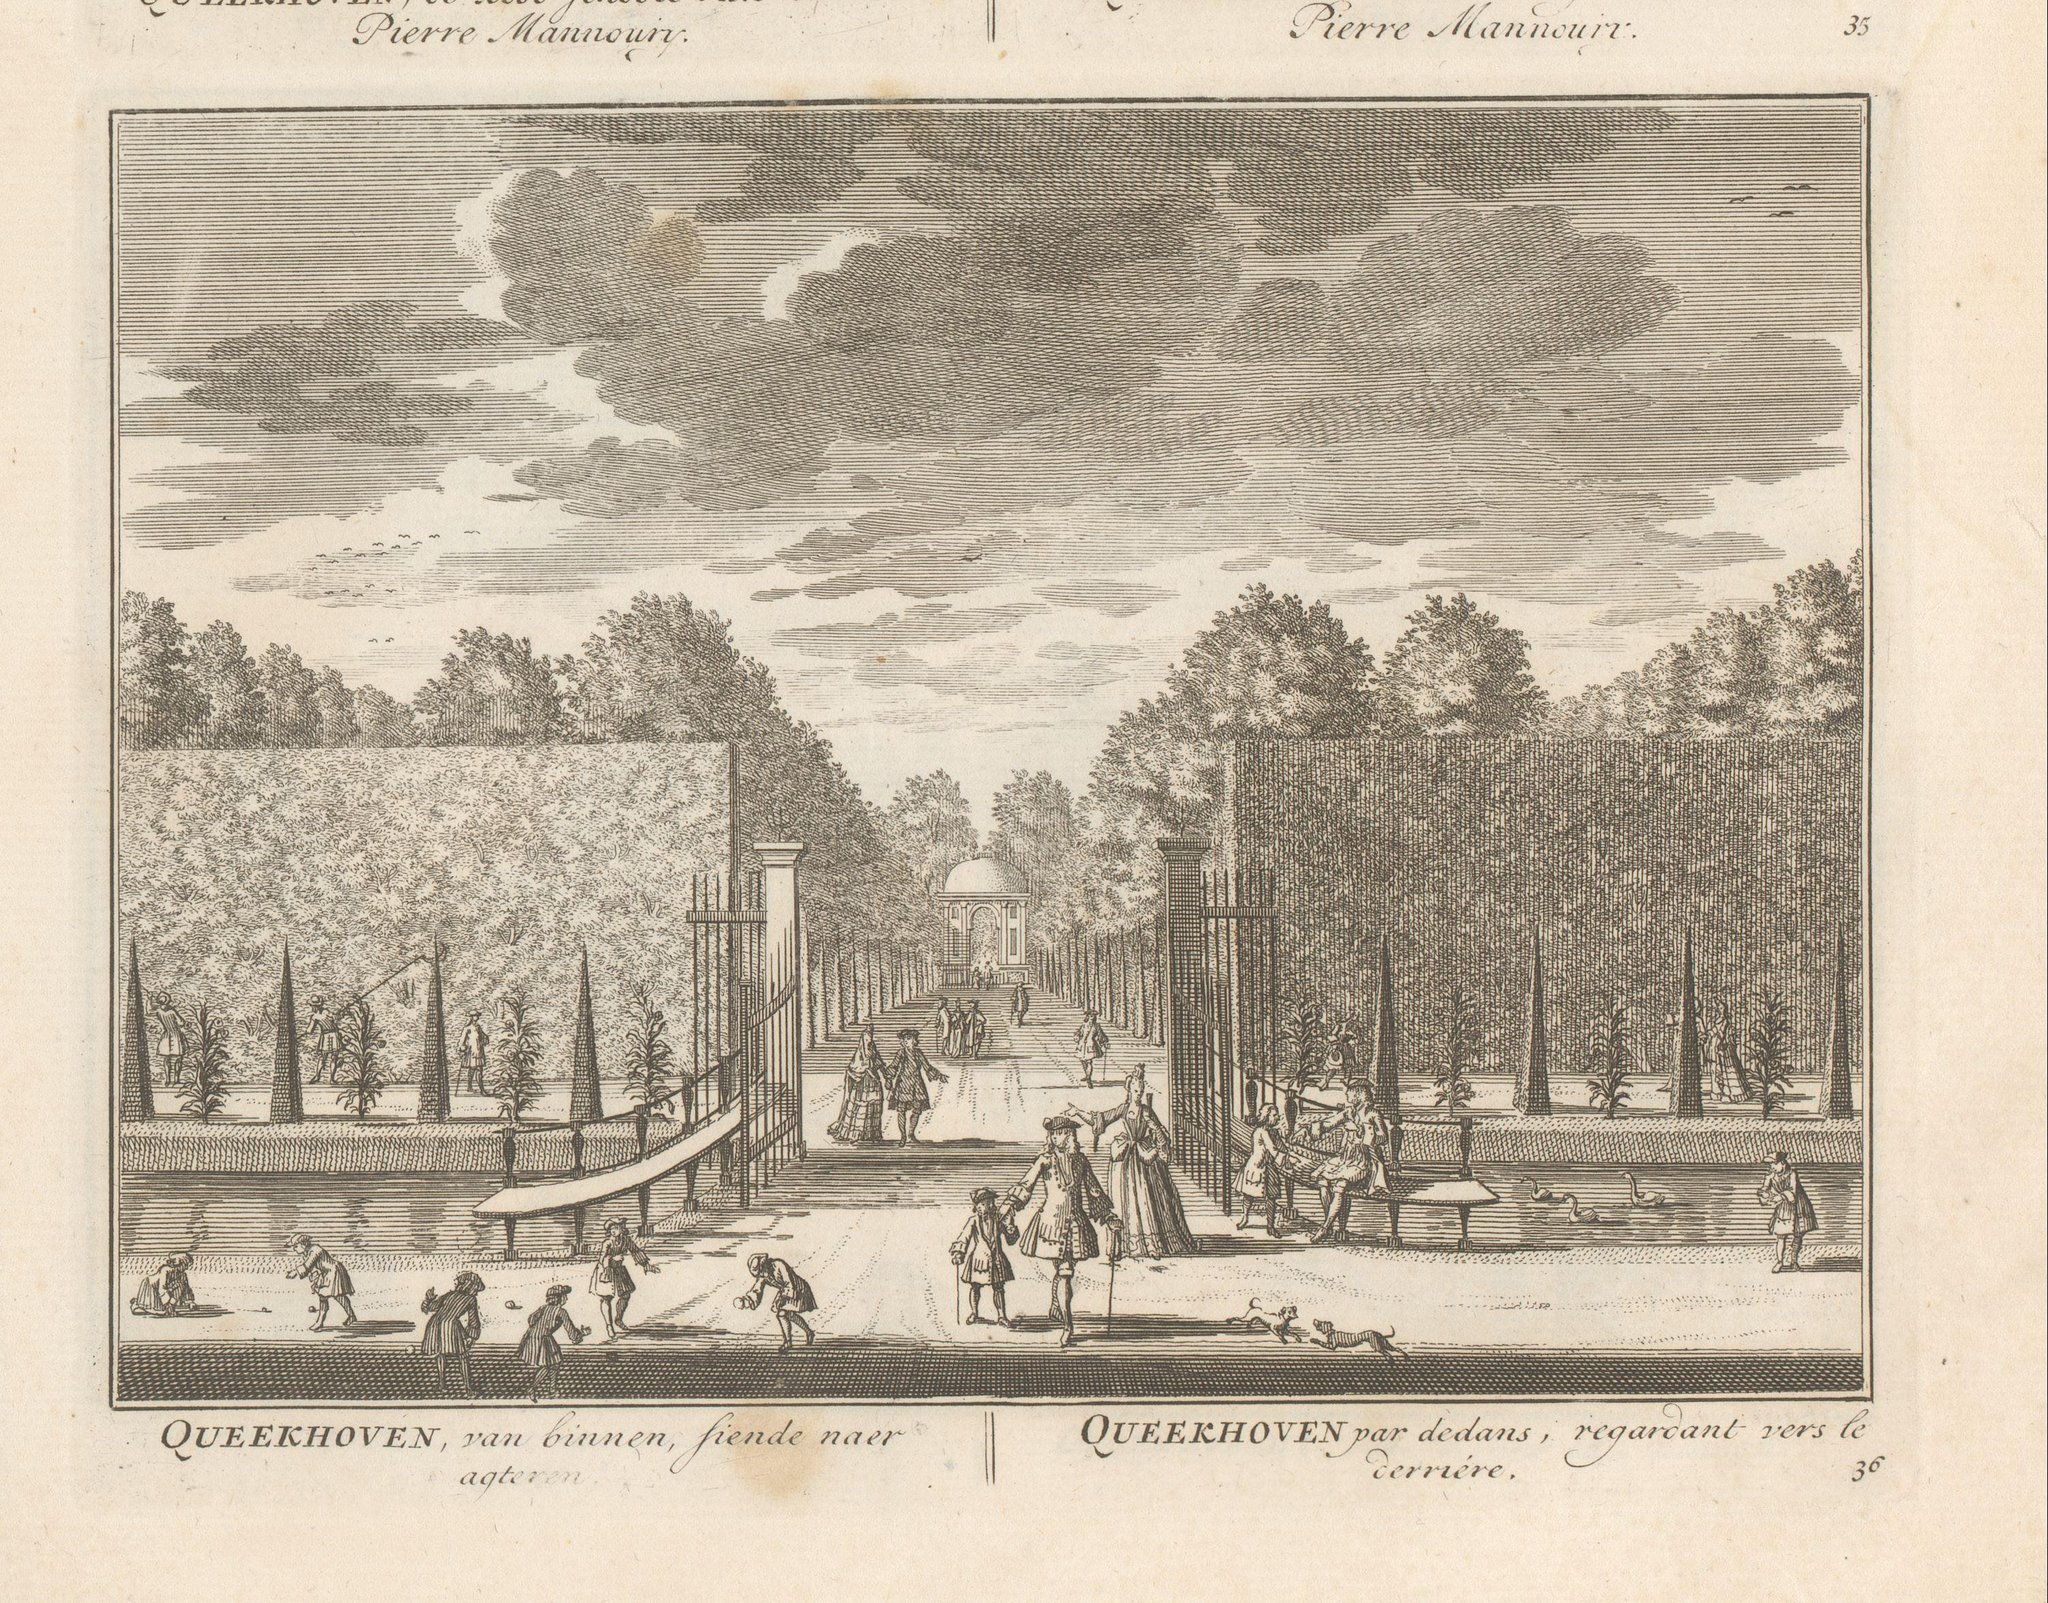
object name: print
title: Queekhoven, van binnen, siende naer agteren / Queekhoven par dedans, regardant vers le derriére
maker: daniël stopendaal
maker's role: print maker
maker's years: 1672-1726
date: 1790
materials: paper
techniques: engraving, etching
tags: french or architectonic garden; formal garden, gate, entrance, vecht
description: Prent gebruikt in: Leth, Andries de. De zegepraalende Vecht, vertoonende verscheidene gesichten van lustplaatsen, heeren huysen en dorpen, beginnende van Uitrecht en met Muyden besluytende (...). Amsterdam: Weduwe Nicolaus Visscher, 1719. Prent ook gebruikt in: Brouërius van Nidek, Matthaeus. De Vechtstroom, van Utrecht tot Muiden (...). Amsterdam: H. Gartman, W. Vermandel en J.W. Smit, 1790.